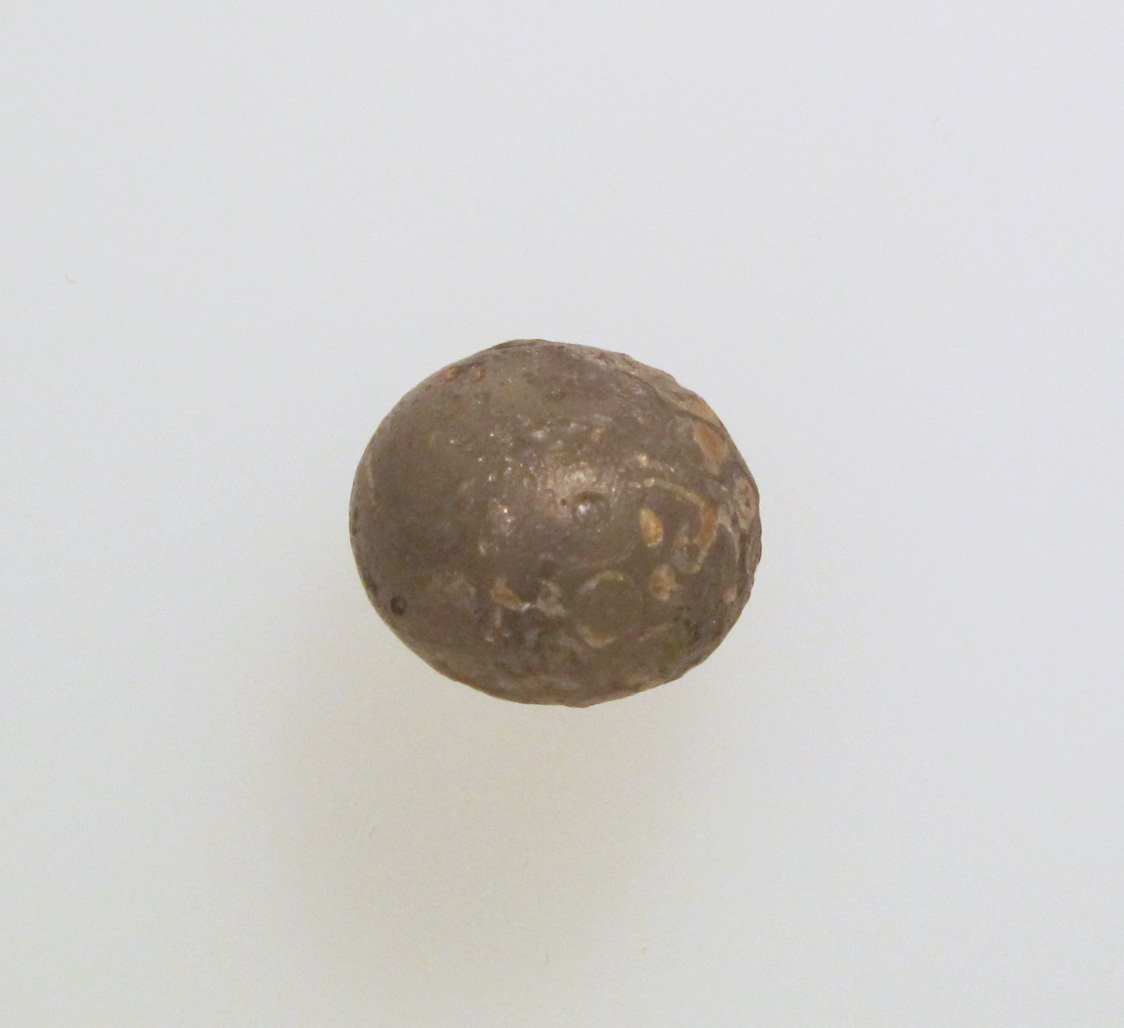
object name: pinhead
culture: roman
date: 670 BCE-330 CE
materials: glass